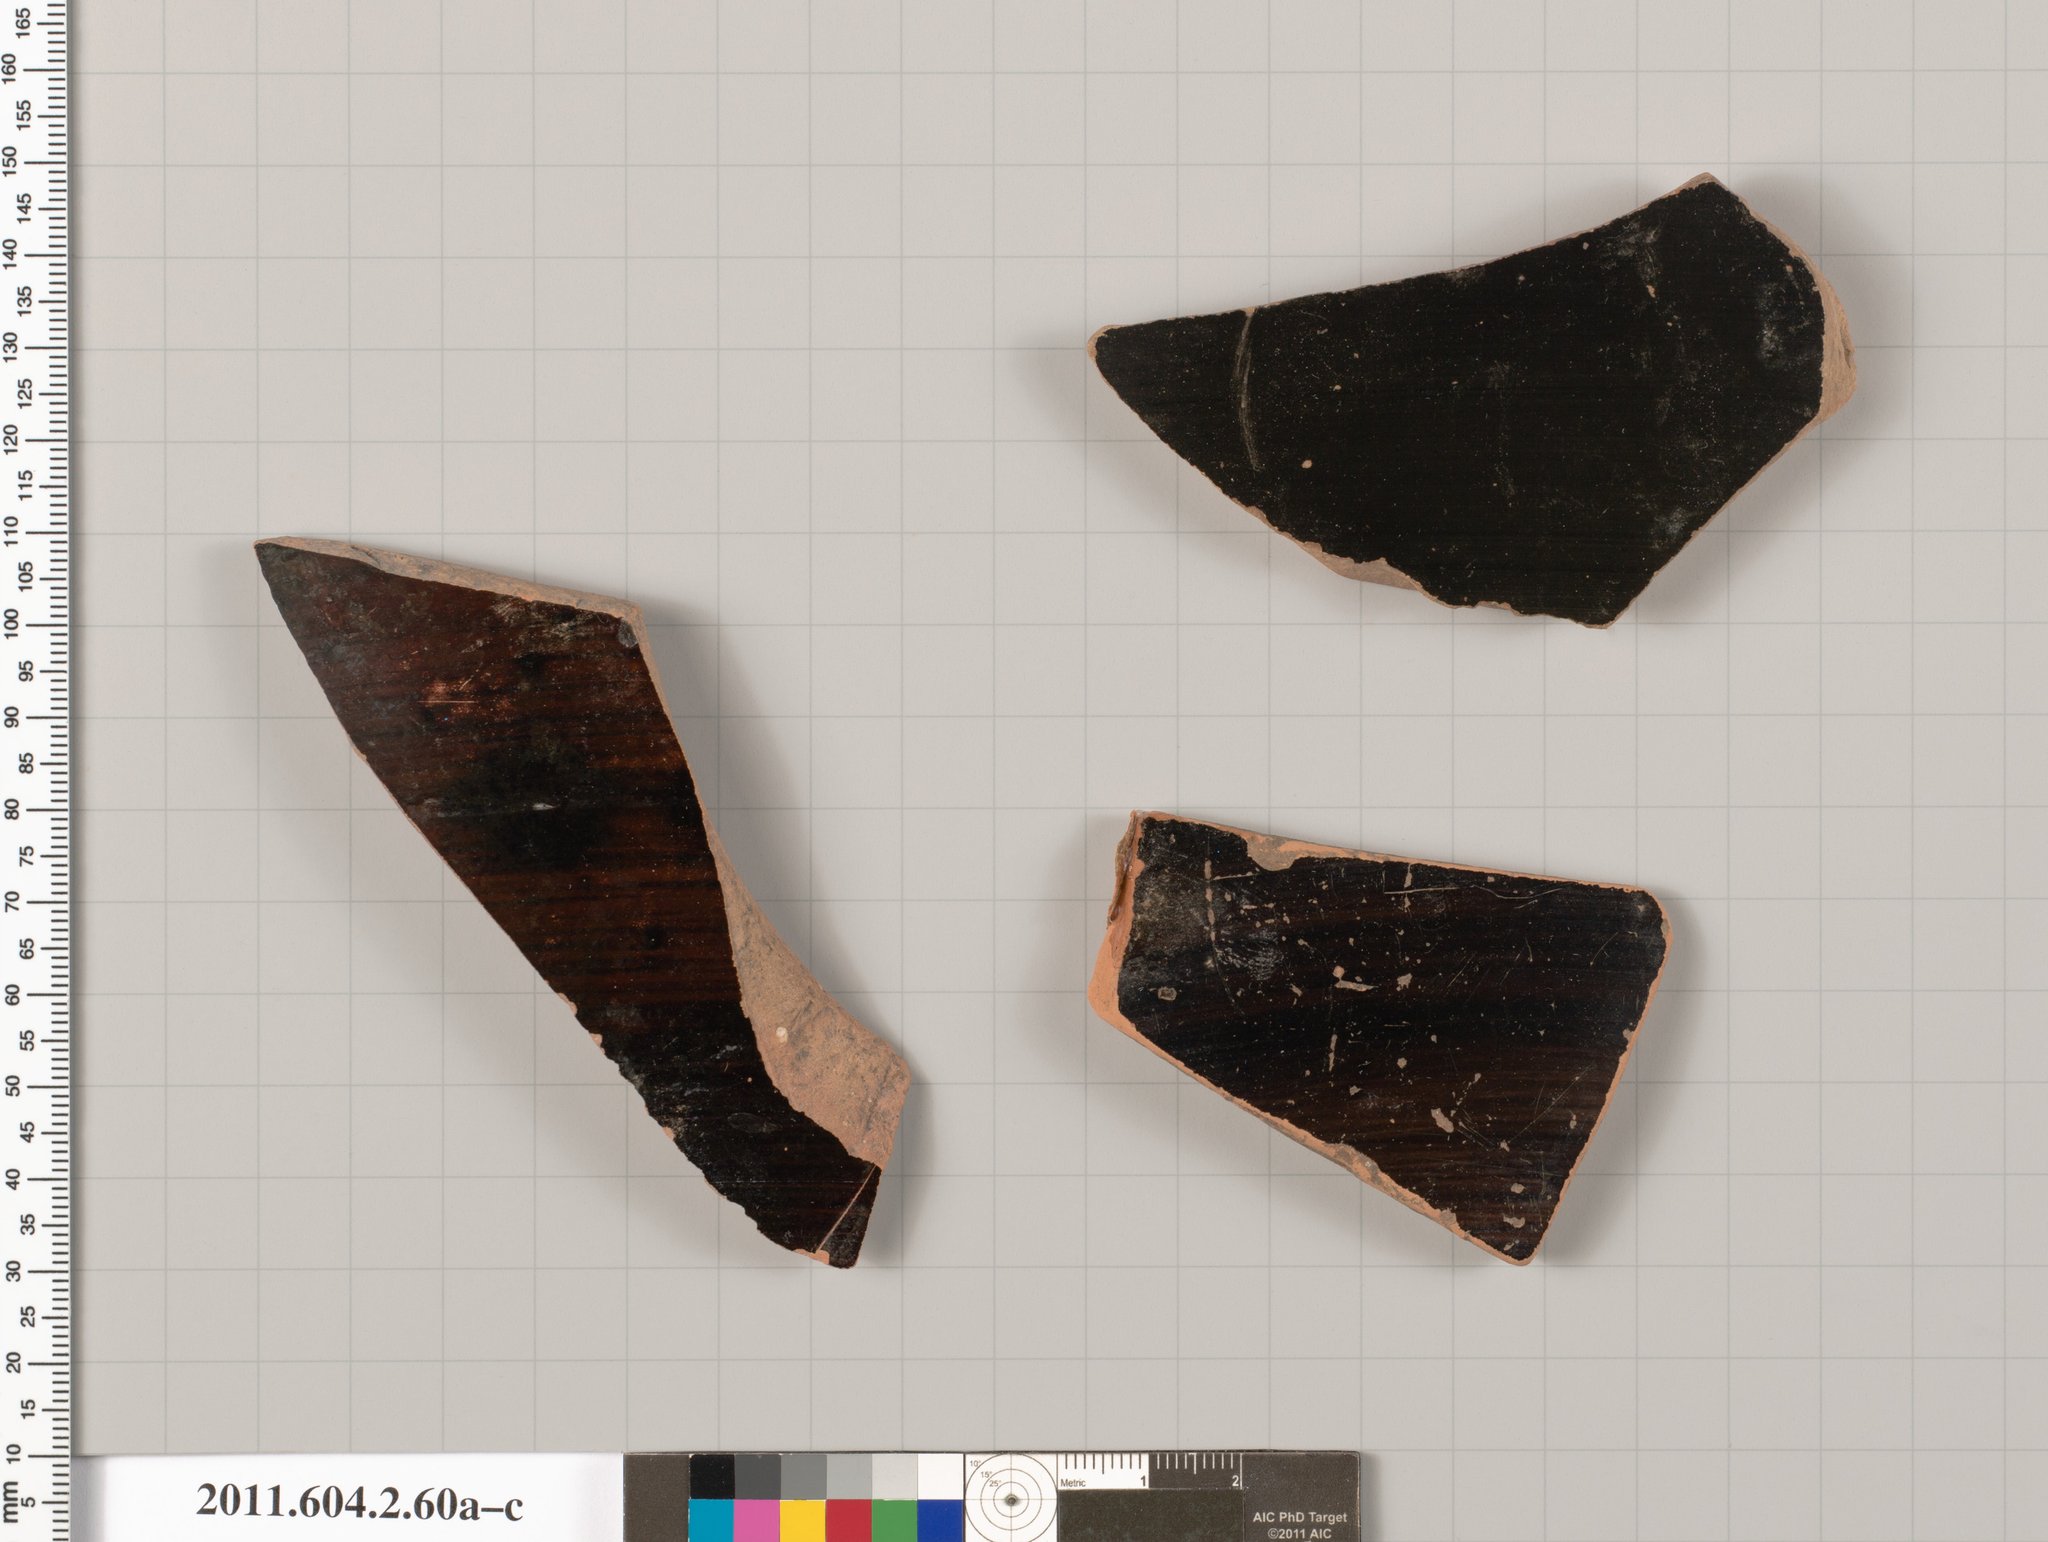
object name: pot fragment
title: Terracotta fragments of pots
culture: greek, attic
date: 534-468 BCE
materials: terracotta